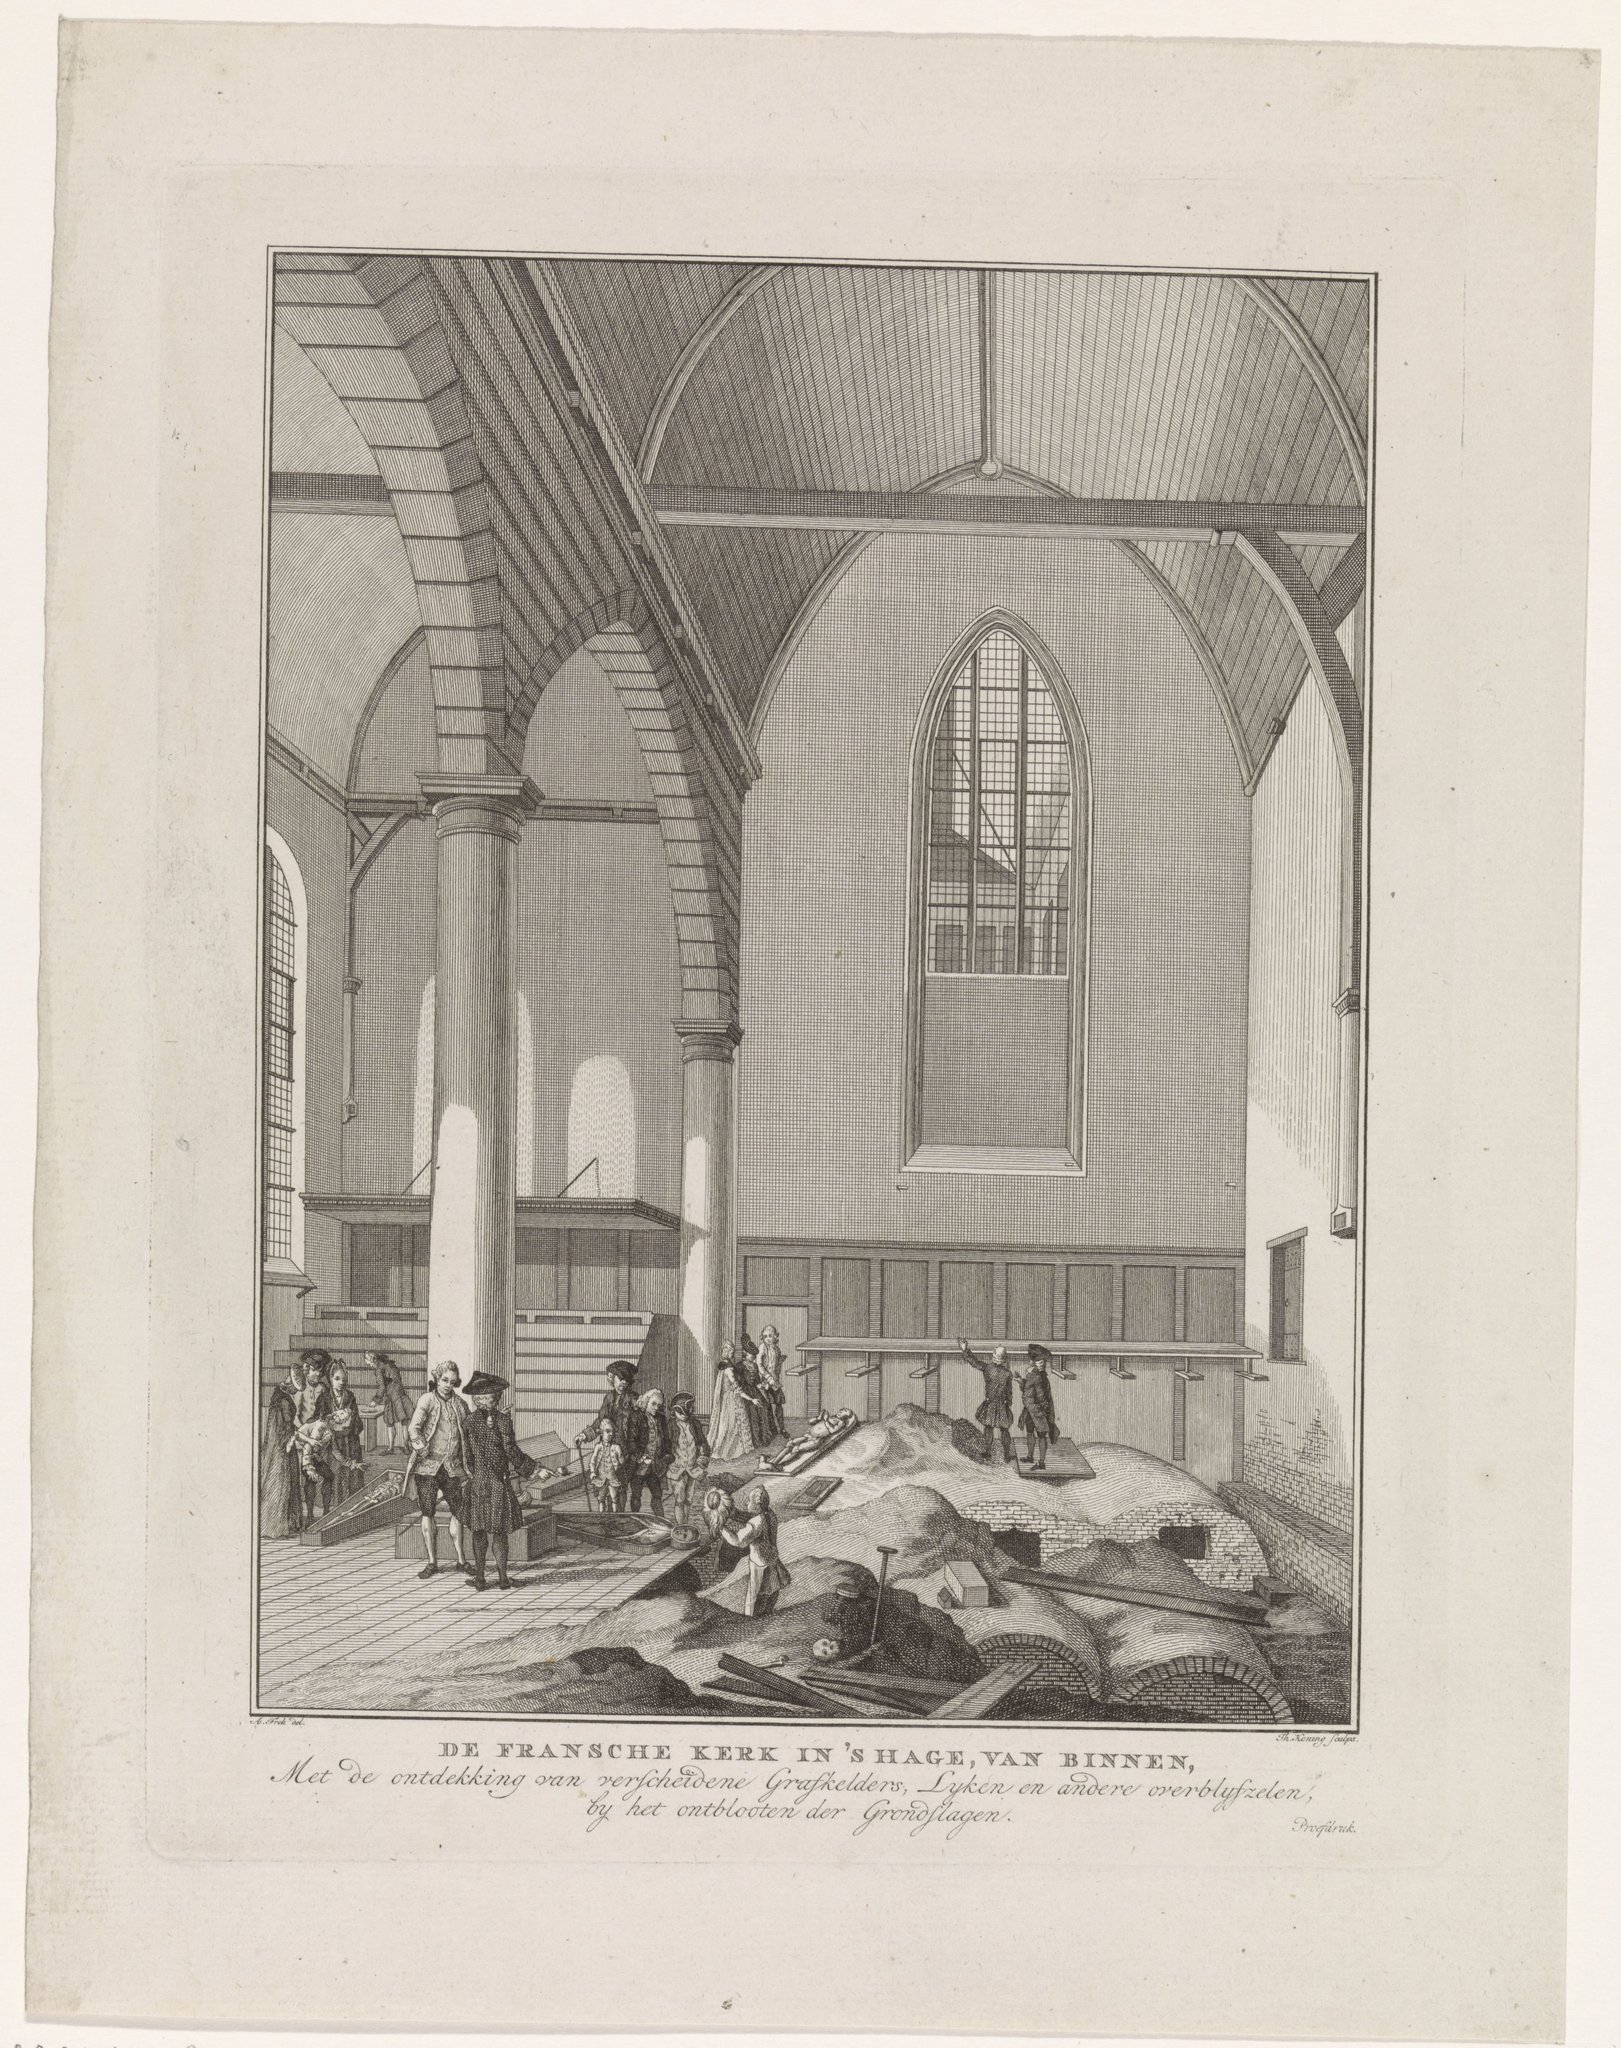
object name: print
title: De Fransche Kerk in 's Hage, van binnen, Met de ontdekking van verscheidene Grafkelders, Lyken en andere overblyfzelen, by het ontblooten der Grondslagen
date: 1770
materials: paper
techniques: engraving, etching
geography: northern netherlands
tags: opening of grave, exhumation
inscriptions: collector's mark: Lugt 2228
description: Kerkinterieur met de ontdekking van verschillende grafkleders met lijken tijdens de opgravingen in de Franse Kerk of Hofkapel te Den Haag, maart 1770.